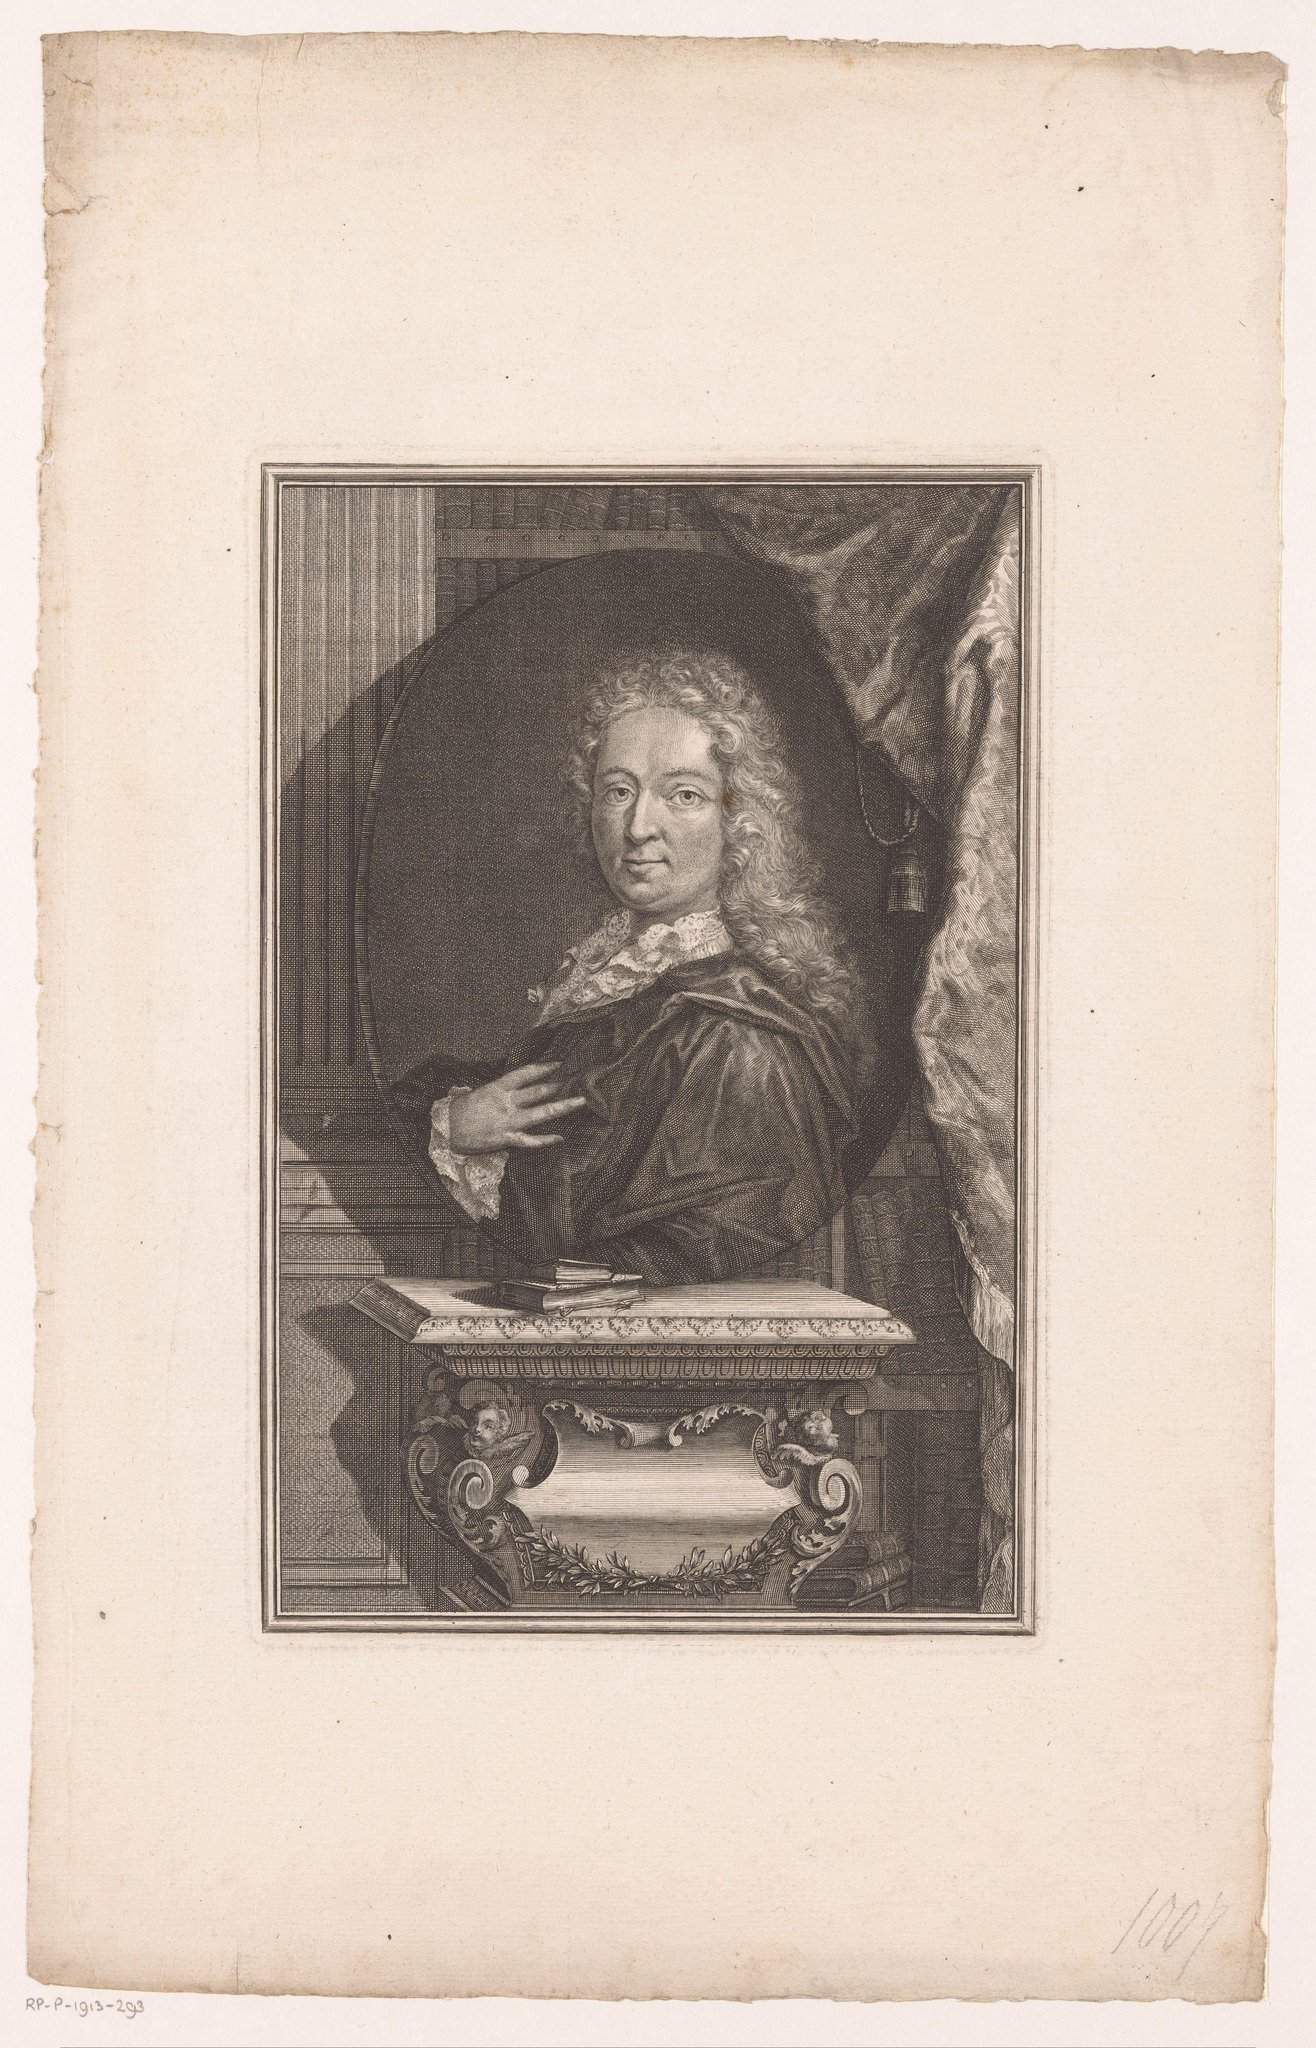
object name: print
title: Portret van Gottfried Thomasius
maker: johann christian marchand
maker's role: print maker, publisher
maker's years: 1680-1711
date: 1690-1711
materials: paper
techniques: engraving, etching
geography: nuremberg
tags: gottfried thomasius, historical persons, book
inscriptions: collector's mark: Lugt 2228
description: Het portret van Gottfried Thomasius in staande ovaal op een sokkel tegen een kastenwand met boeken. Op en naast de sokkel twee en drie boeken. Zonder Griekse tekst.